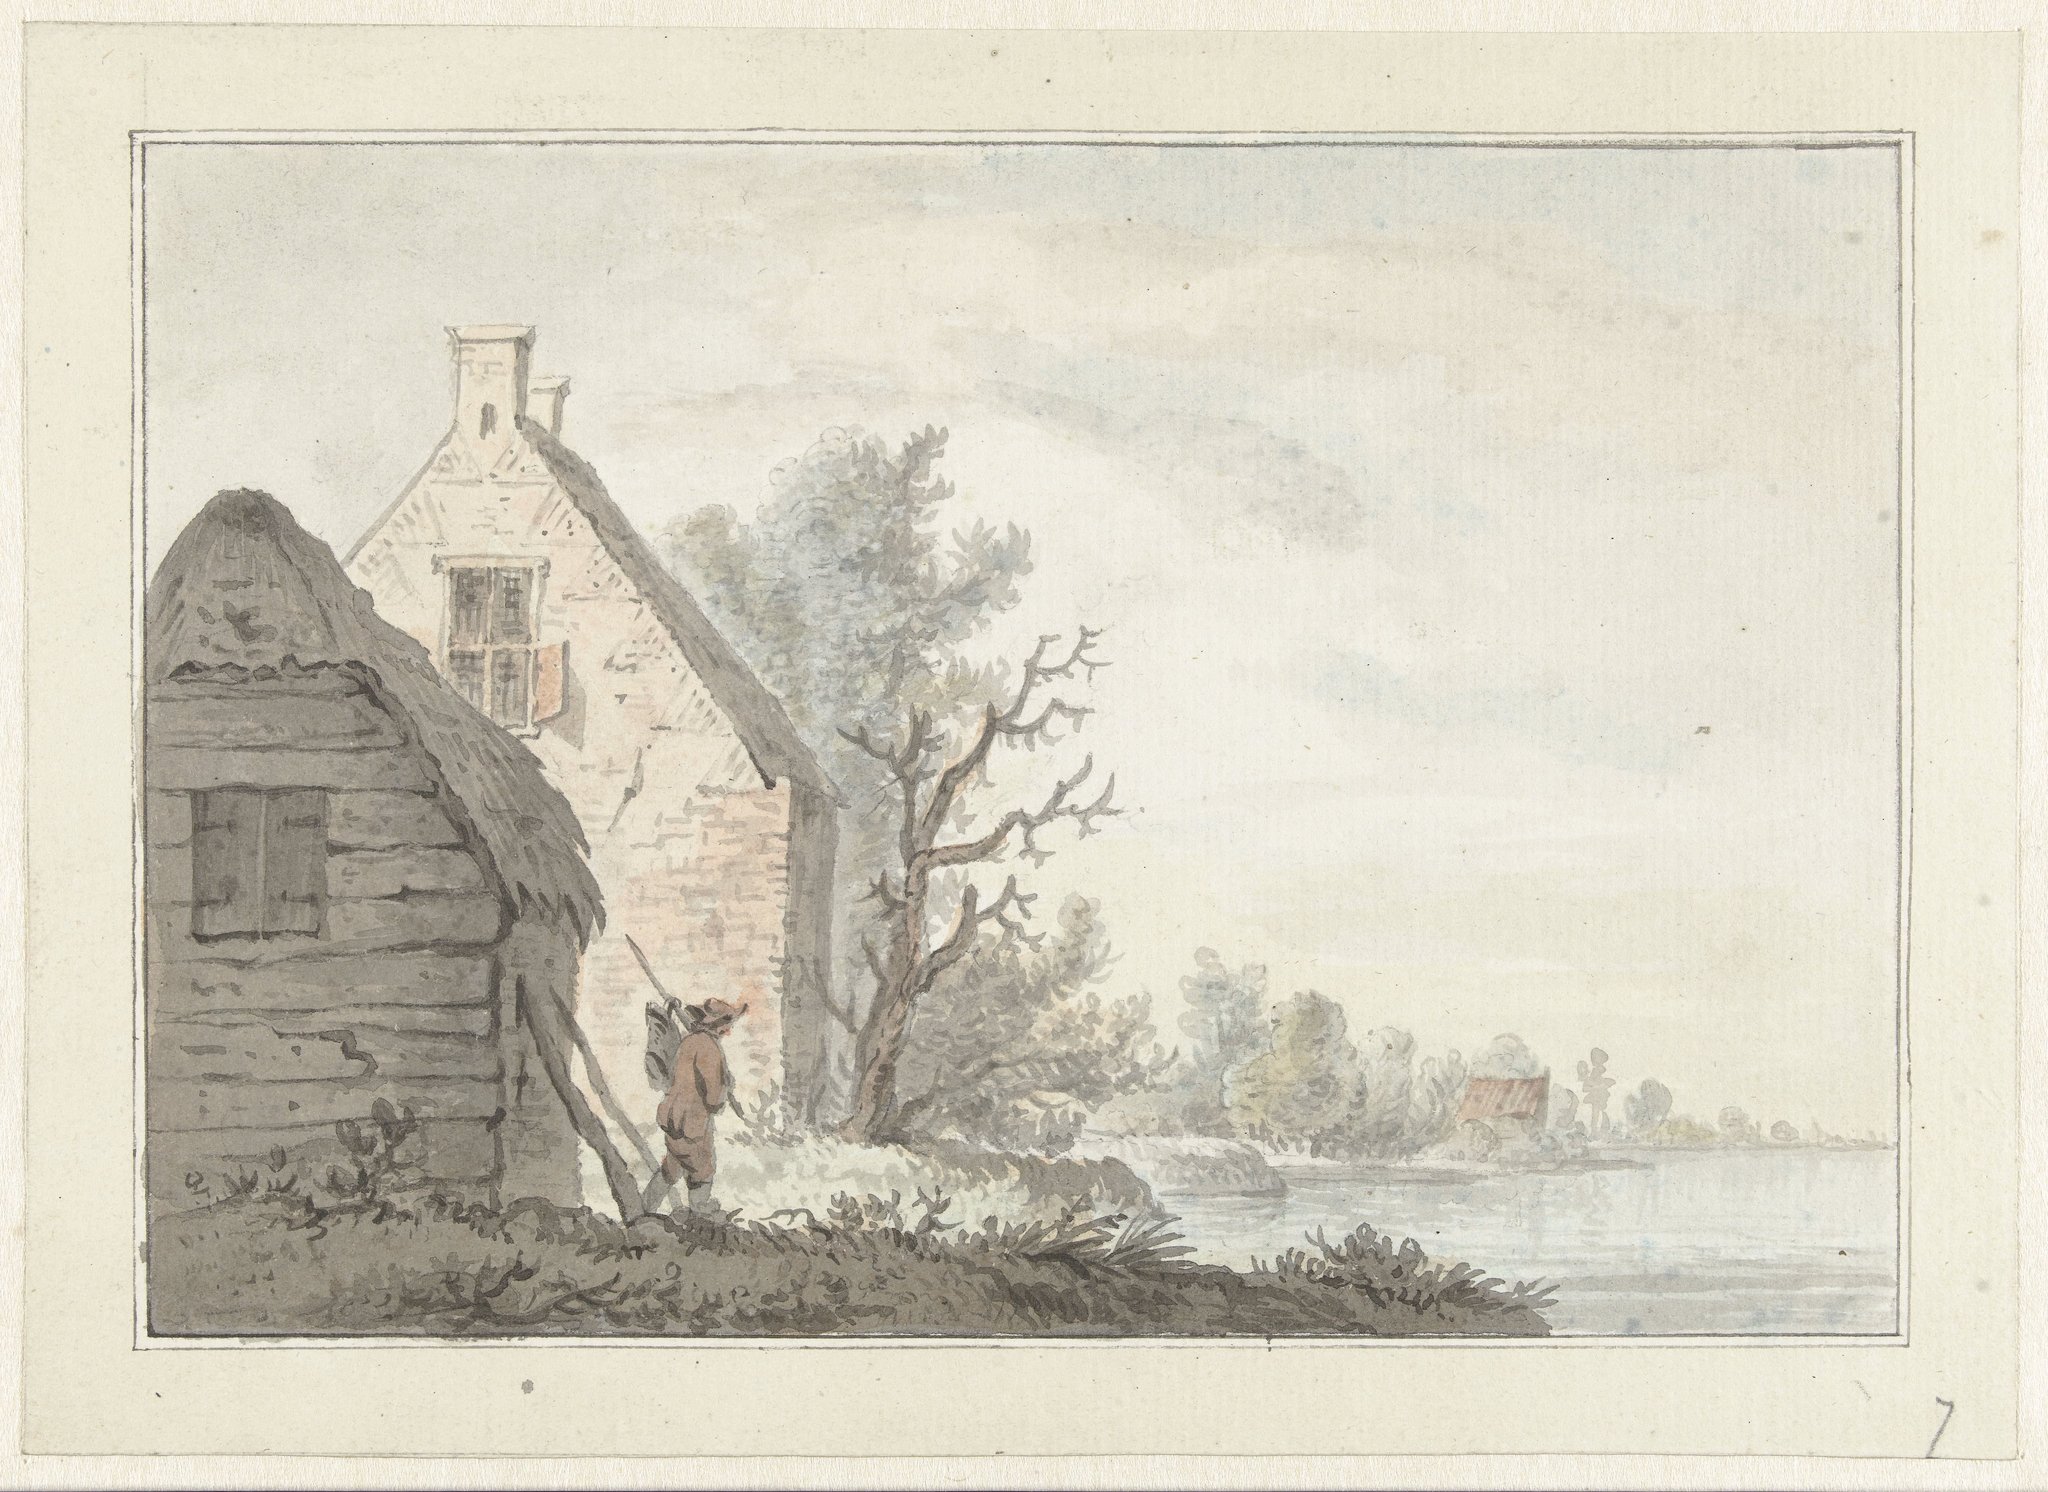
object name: watercolor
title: Rivierlandschap met enige woningen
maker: g. van bosvelt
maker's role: draughtsman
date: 1779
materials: paper, watercolor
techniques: brush